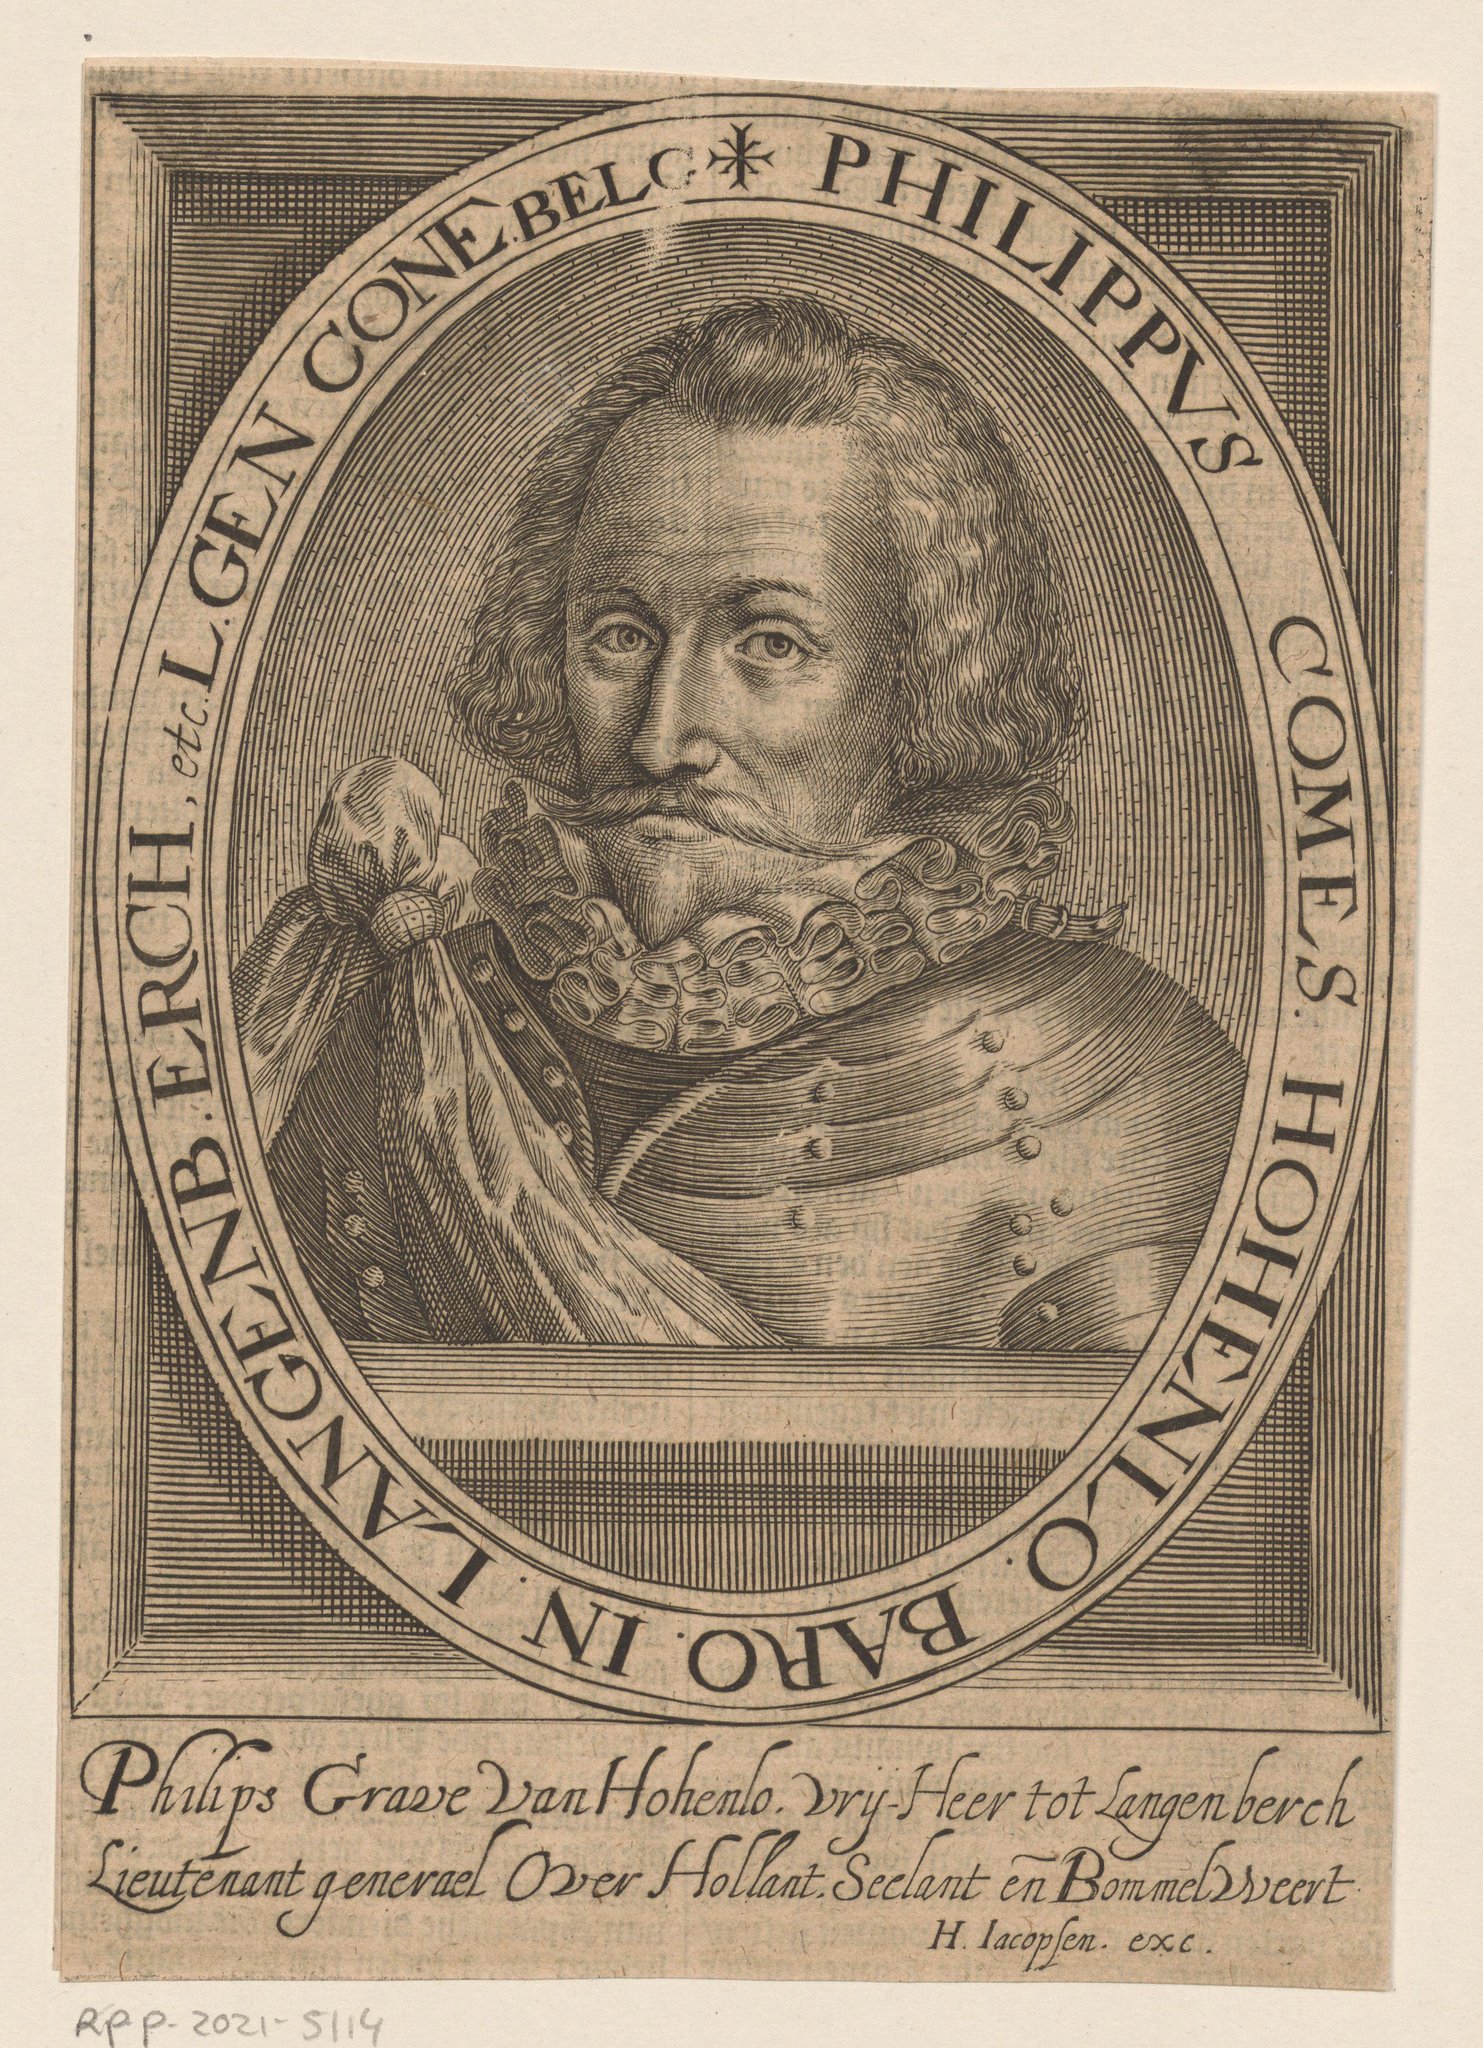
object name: print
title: Portret van Filips, graaf van Hohenlohe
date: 1623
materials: paper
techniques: engraving, letterpress printing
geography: the hague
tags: moustache, adult man, historical persons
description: Prent uit: Meteren, Emanuel van. Historie der Neder-landscher ender haerder na-buren Oorlogen ende geschiedenissen. Den Haag: weduwe Hillebrant Jacobsz van Wouw, 1623.